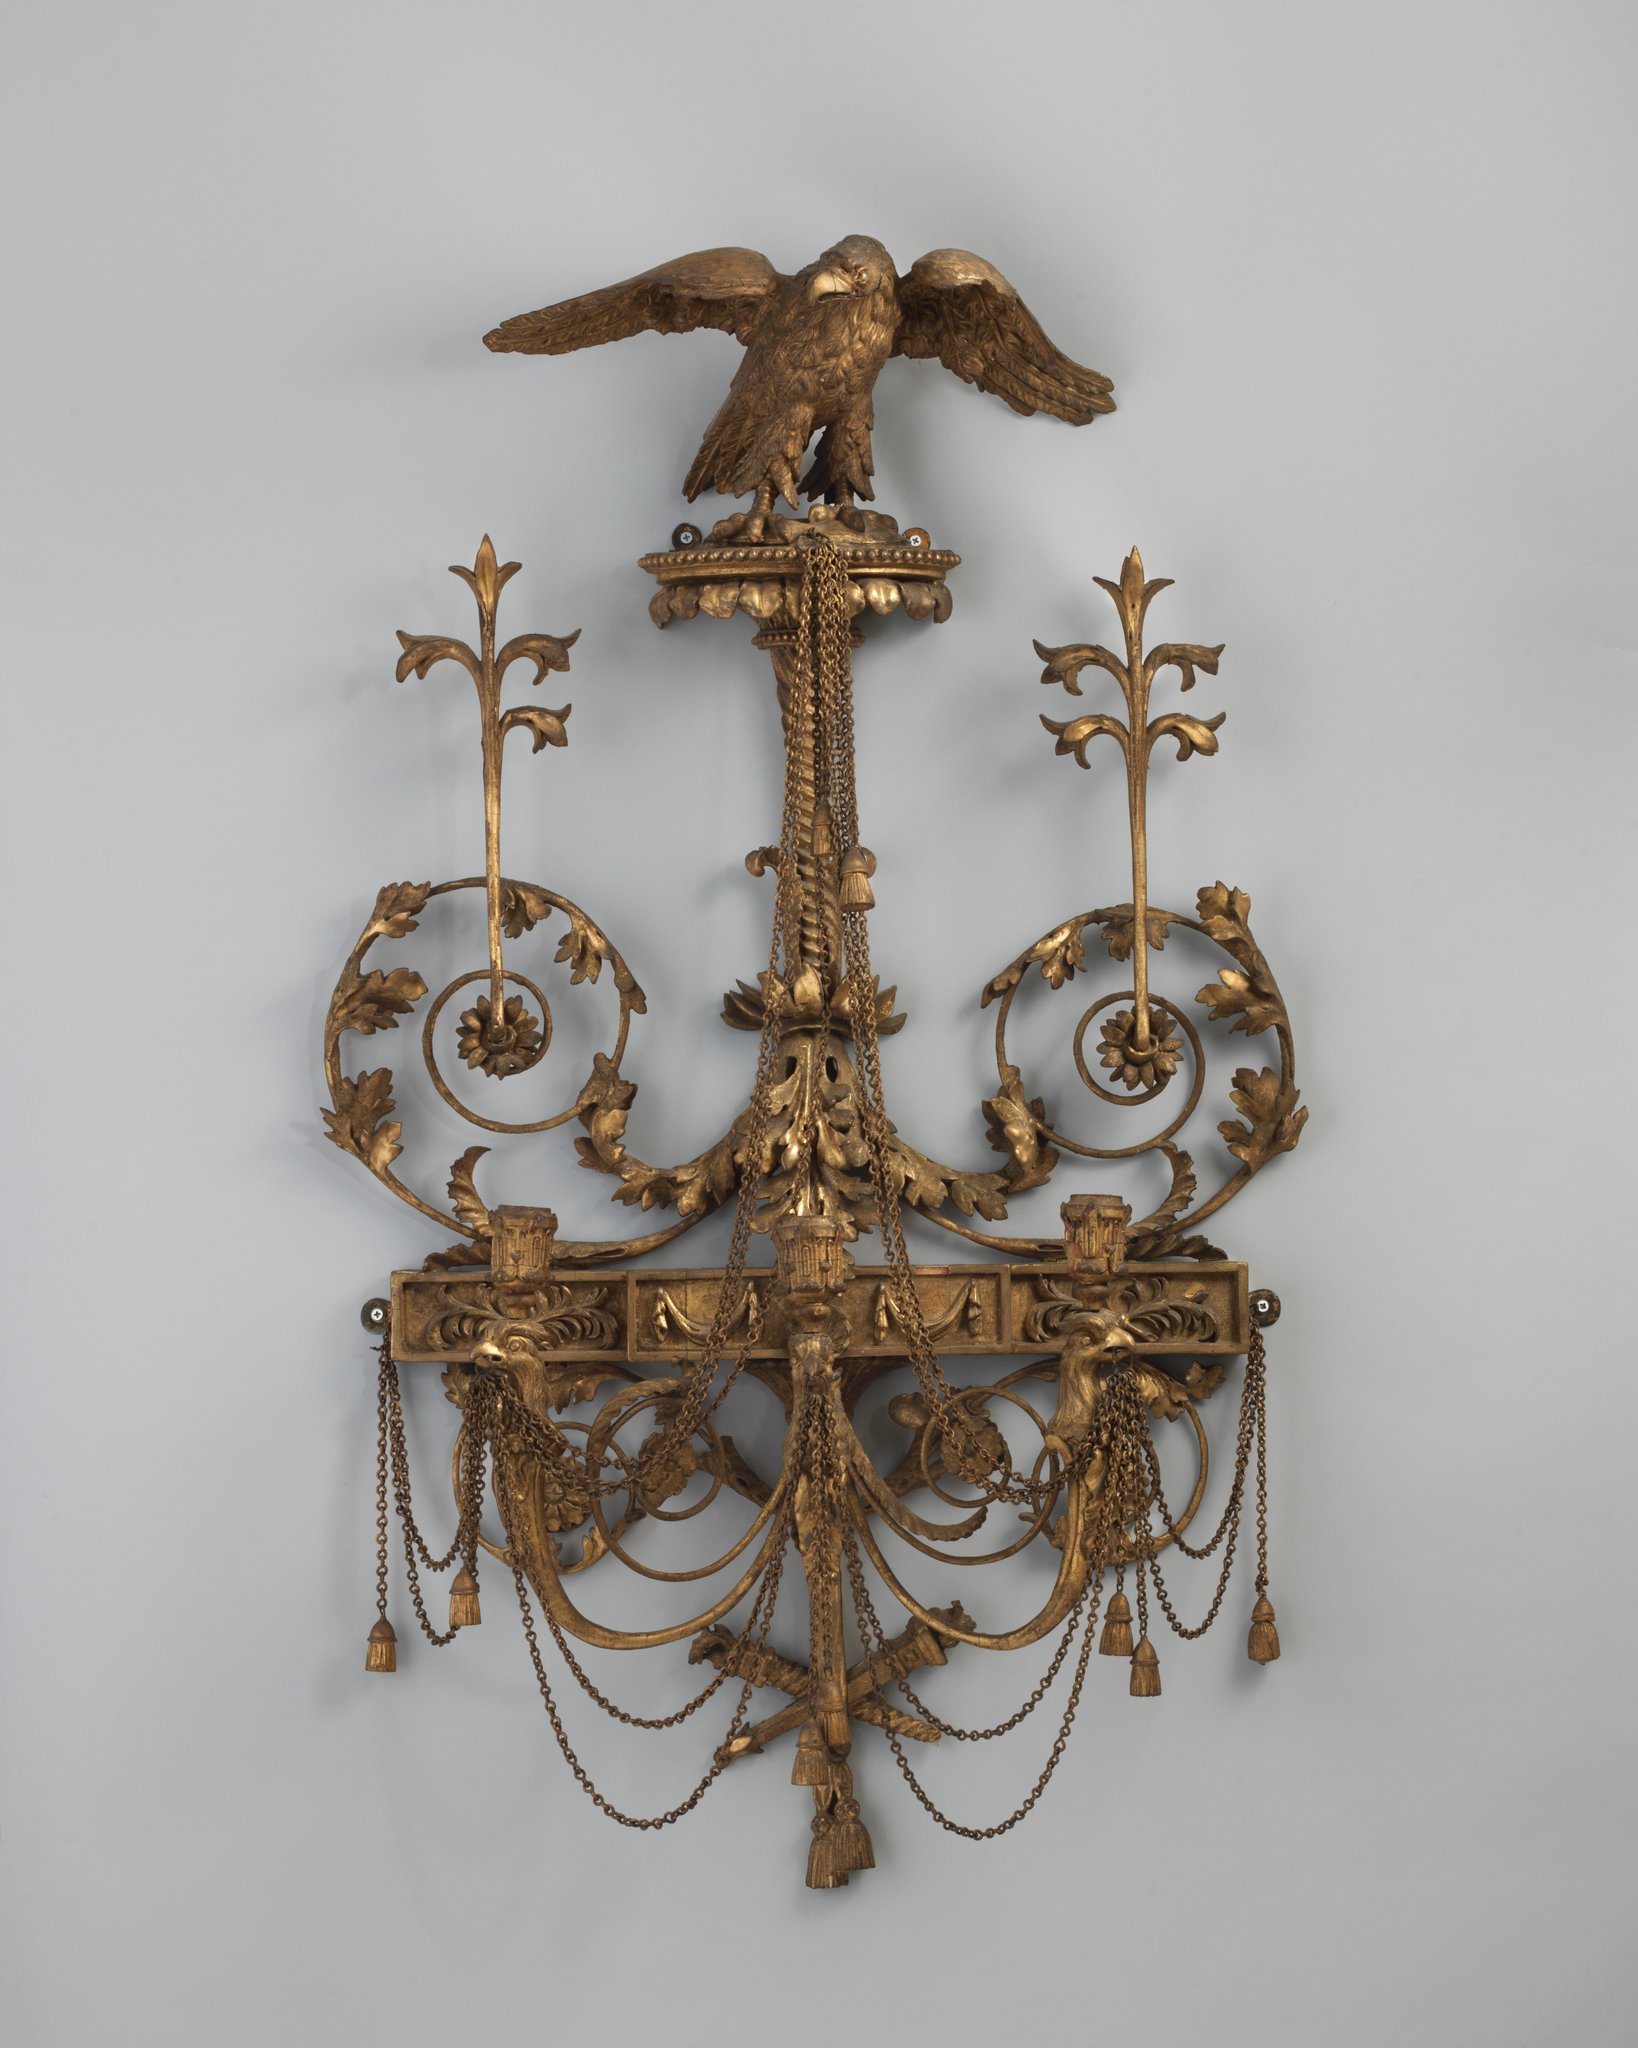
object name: girandole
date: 1767-1800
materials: wood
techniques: gilding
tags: eagles